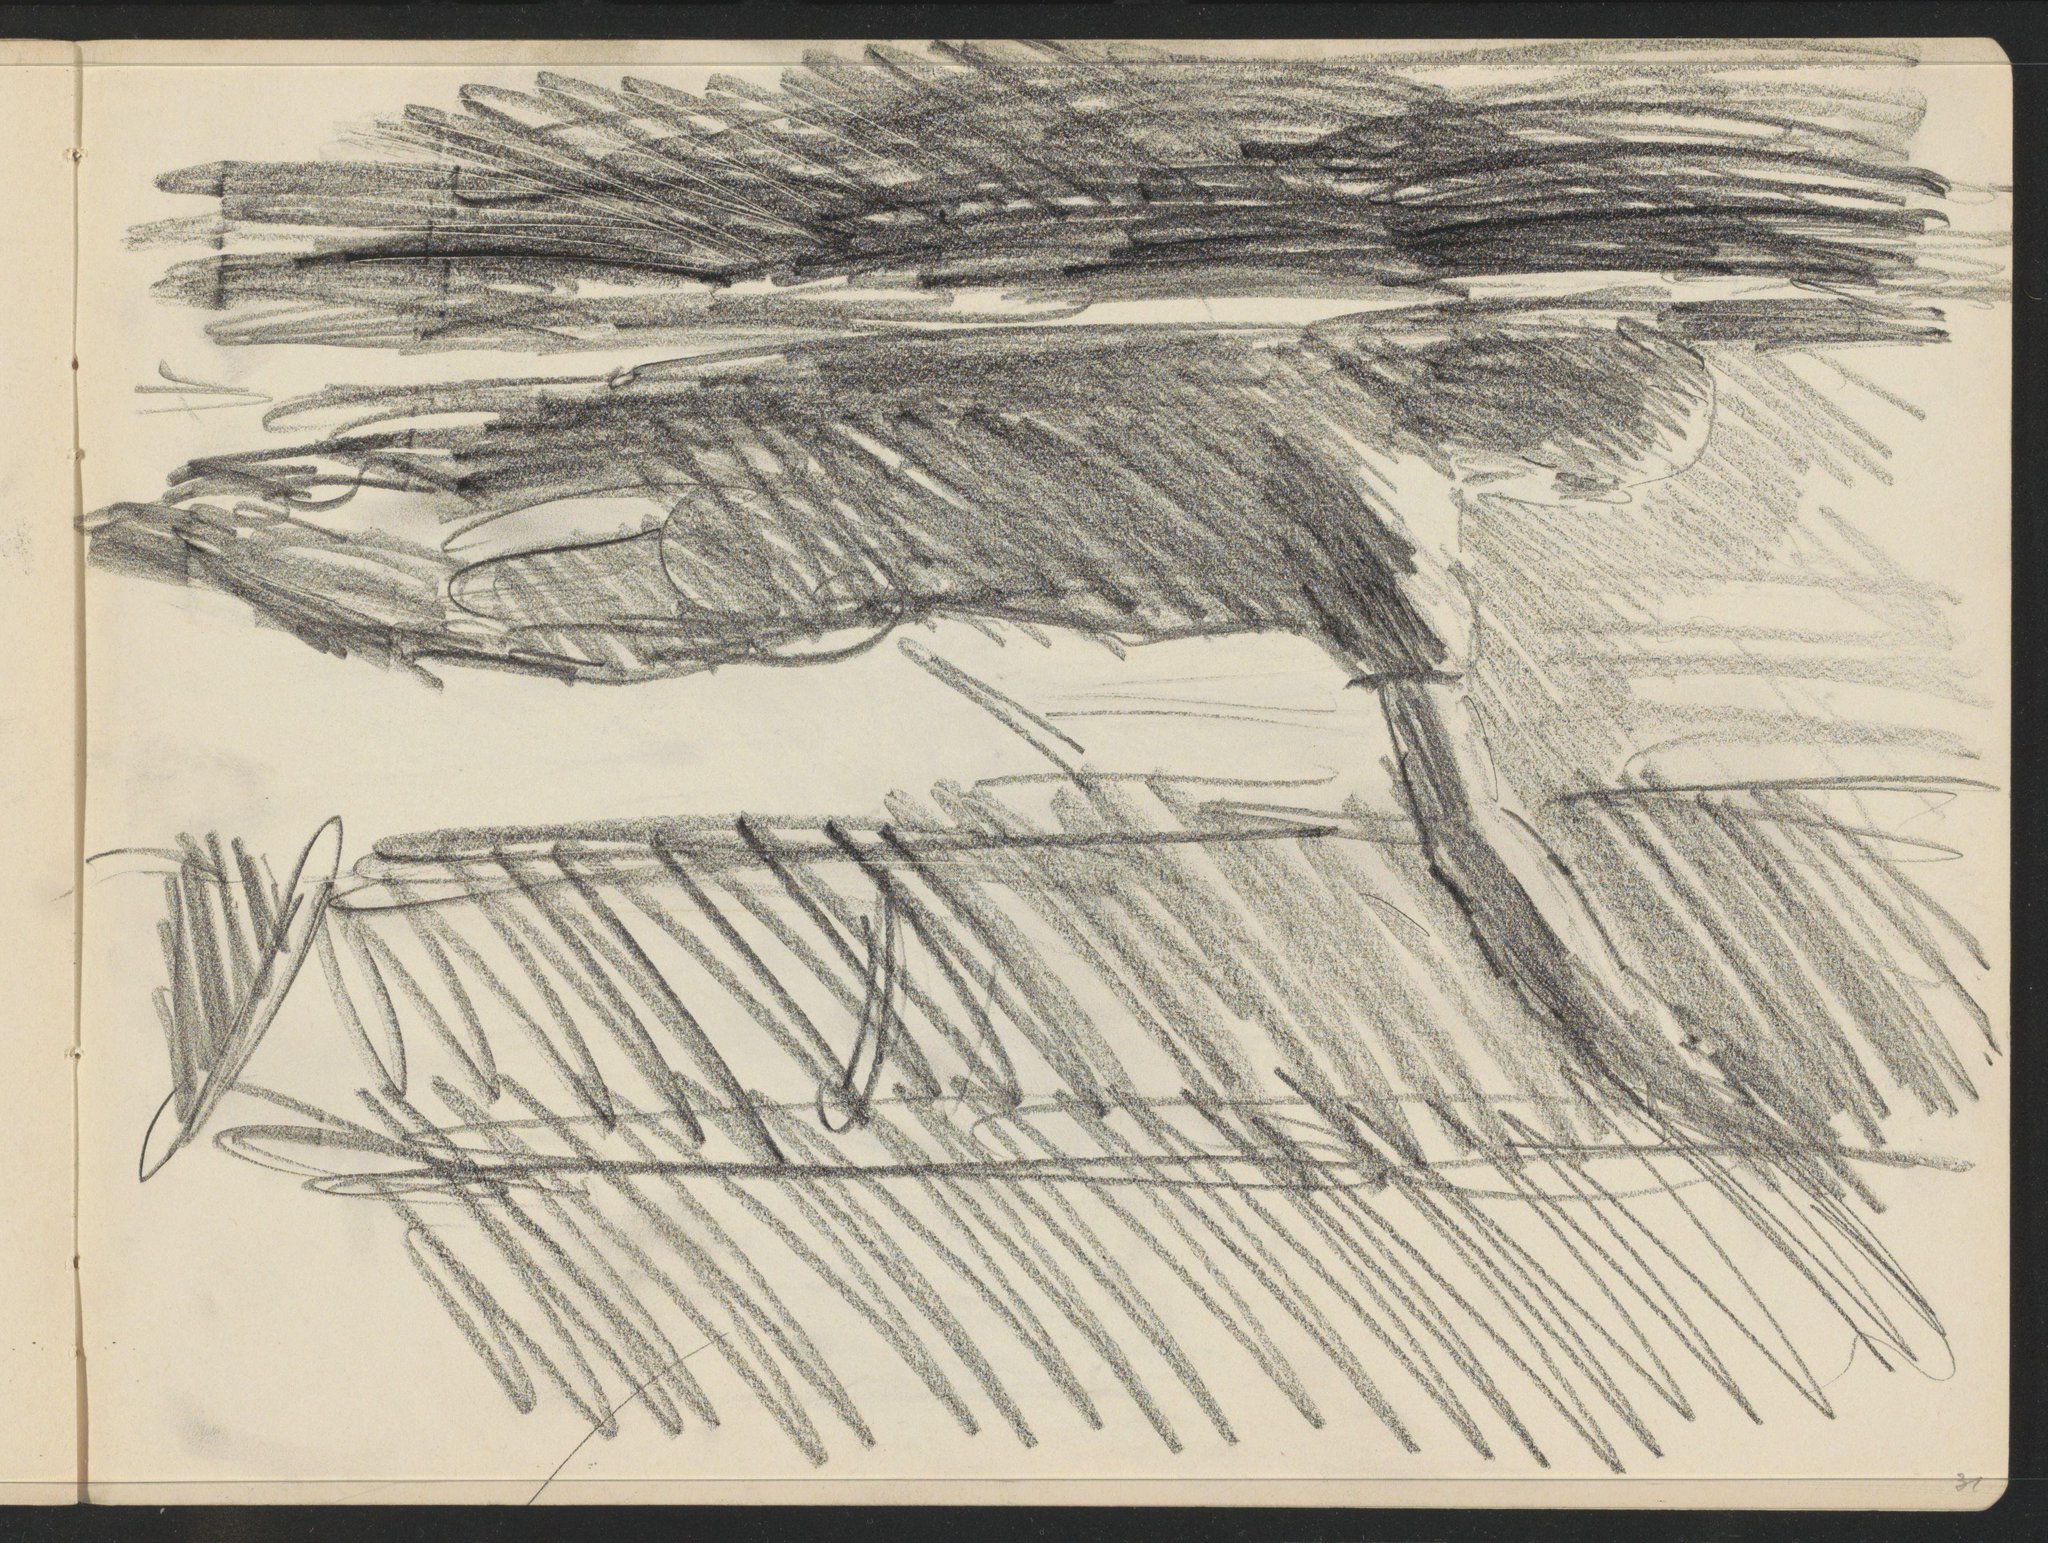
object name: sketchbook leaf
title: Staande figuur, op de rug gezien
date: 1915-1934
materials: paper, pencil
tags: the stage and its equipment, standing figure (+ back view)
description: Met opgeheven arm, mogelijk tussen coulissen. Blad 31 recto uit schetsboek XVI met 32 bladen.